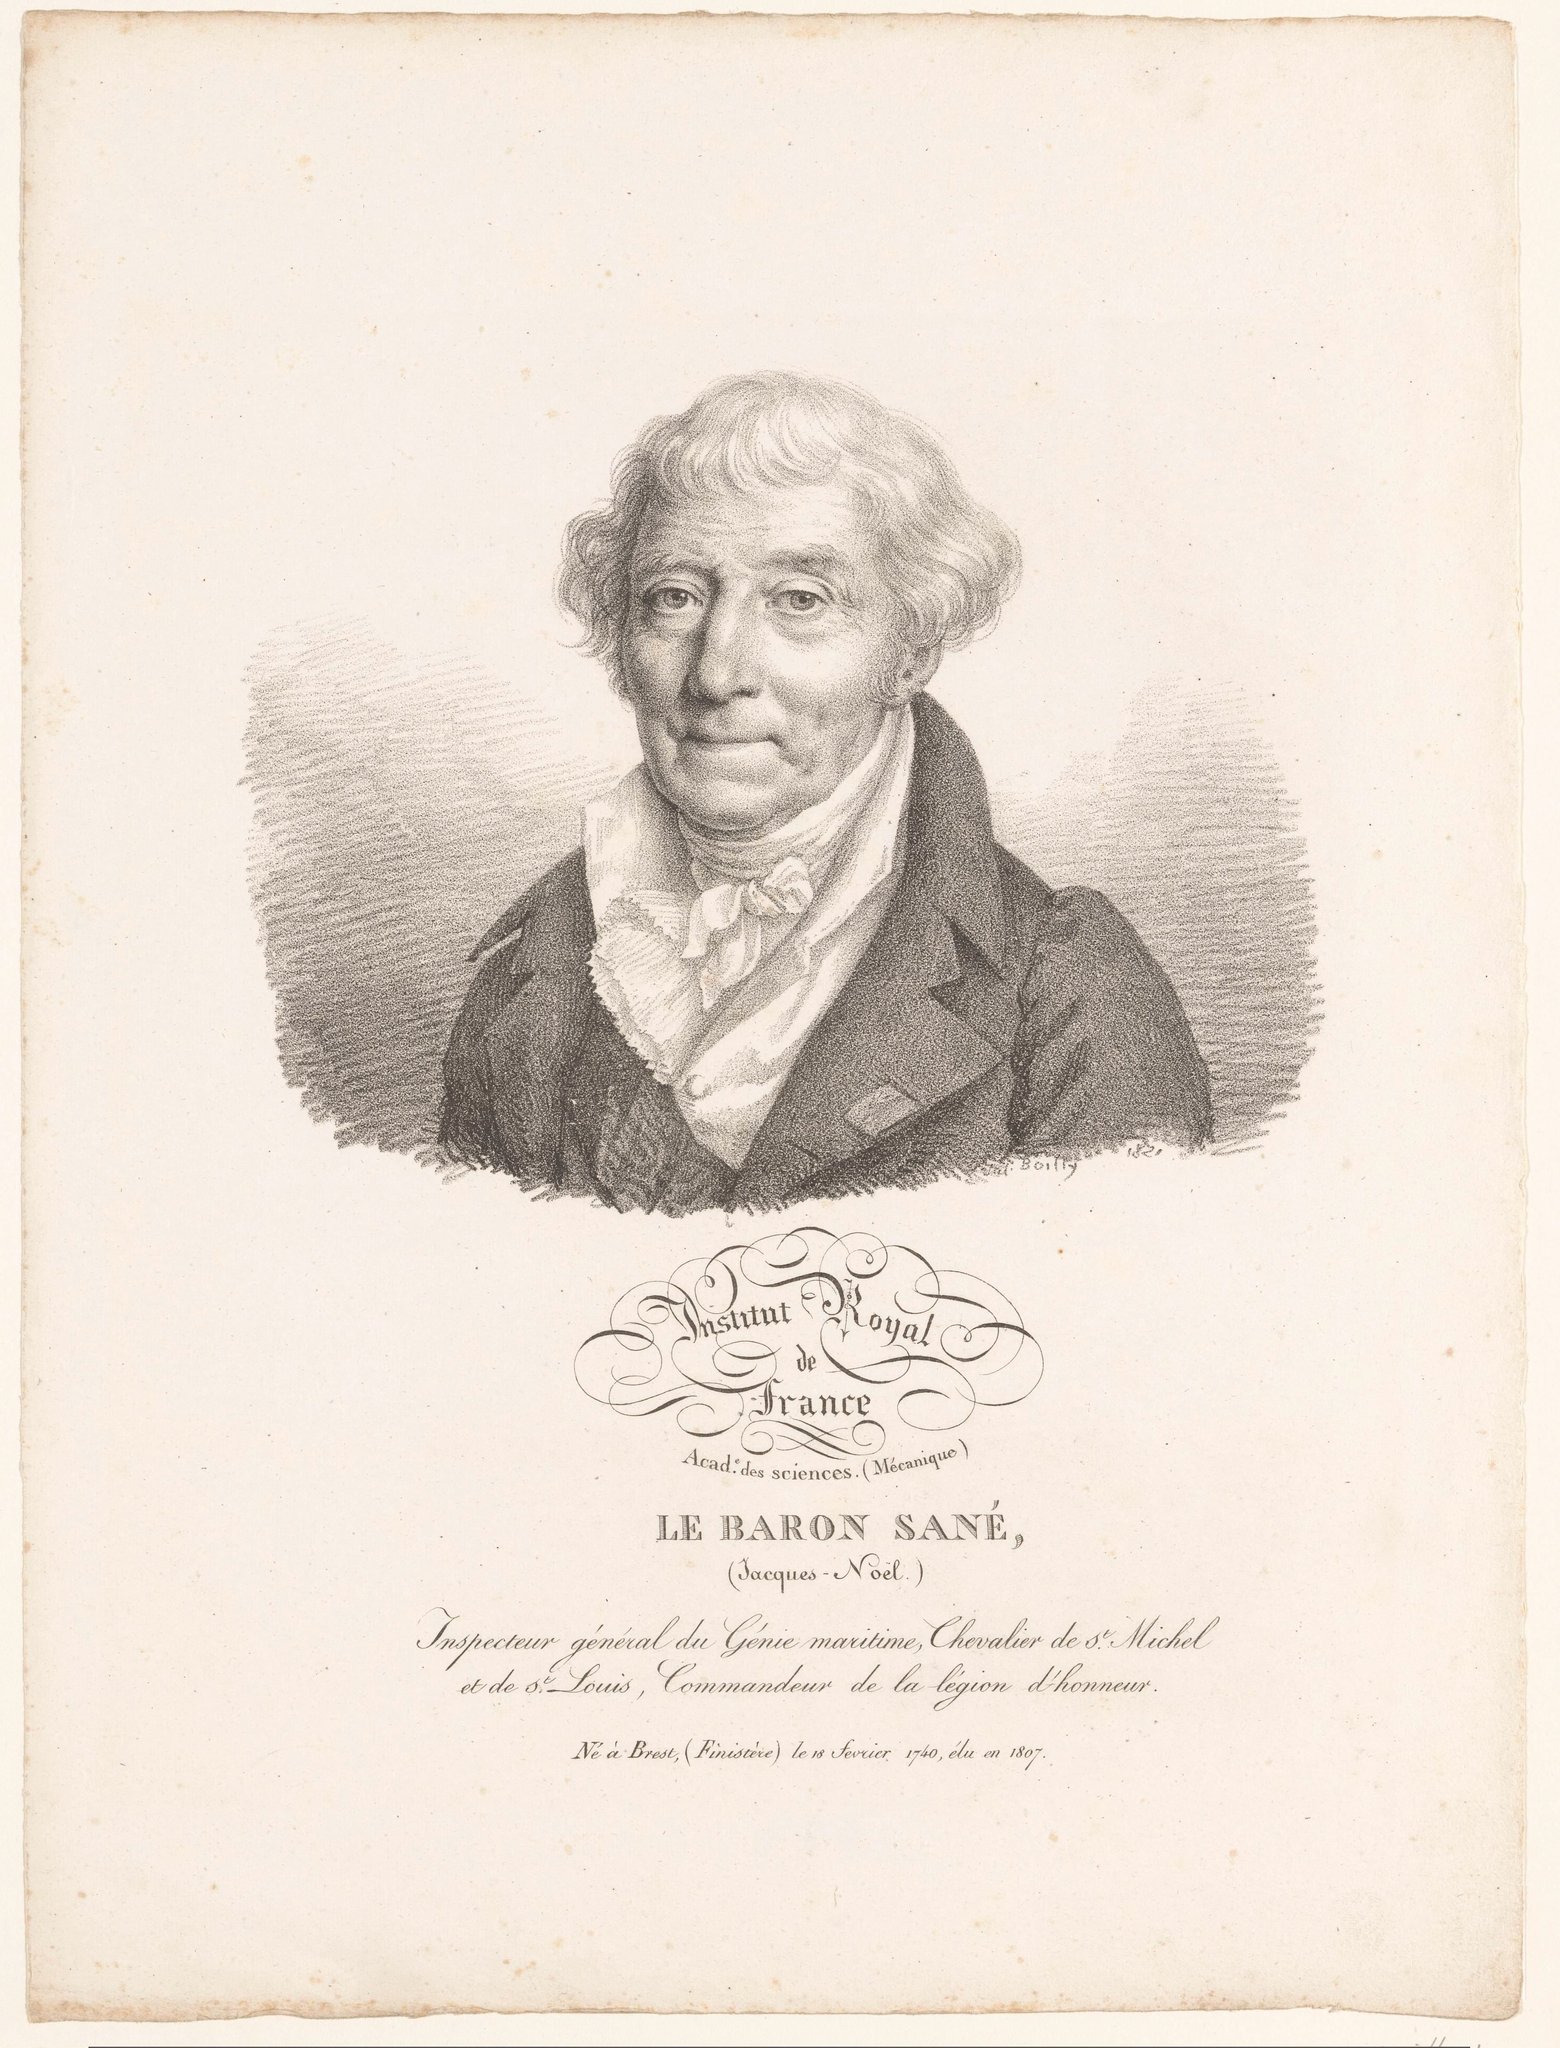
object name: print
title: Iconographie de l'Institut Royal de France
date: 1821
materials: paper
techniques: lithograph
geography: paris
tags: paris, jacques-noël sané, historical persons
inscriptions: collector's mark: Lugt 2228a